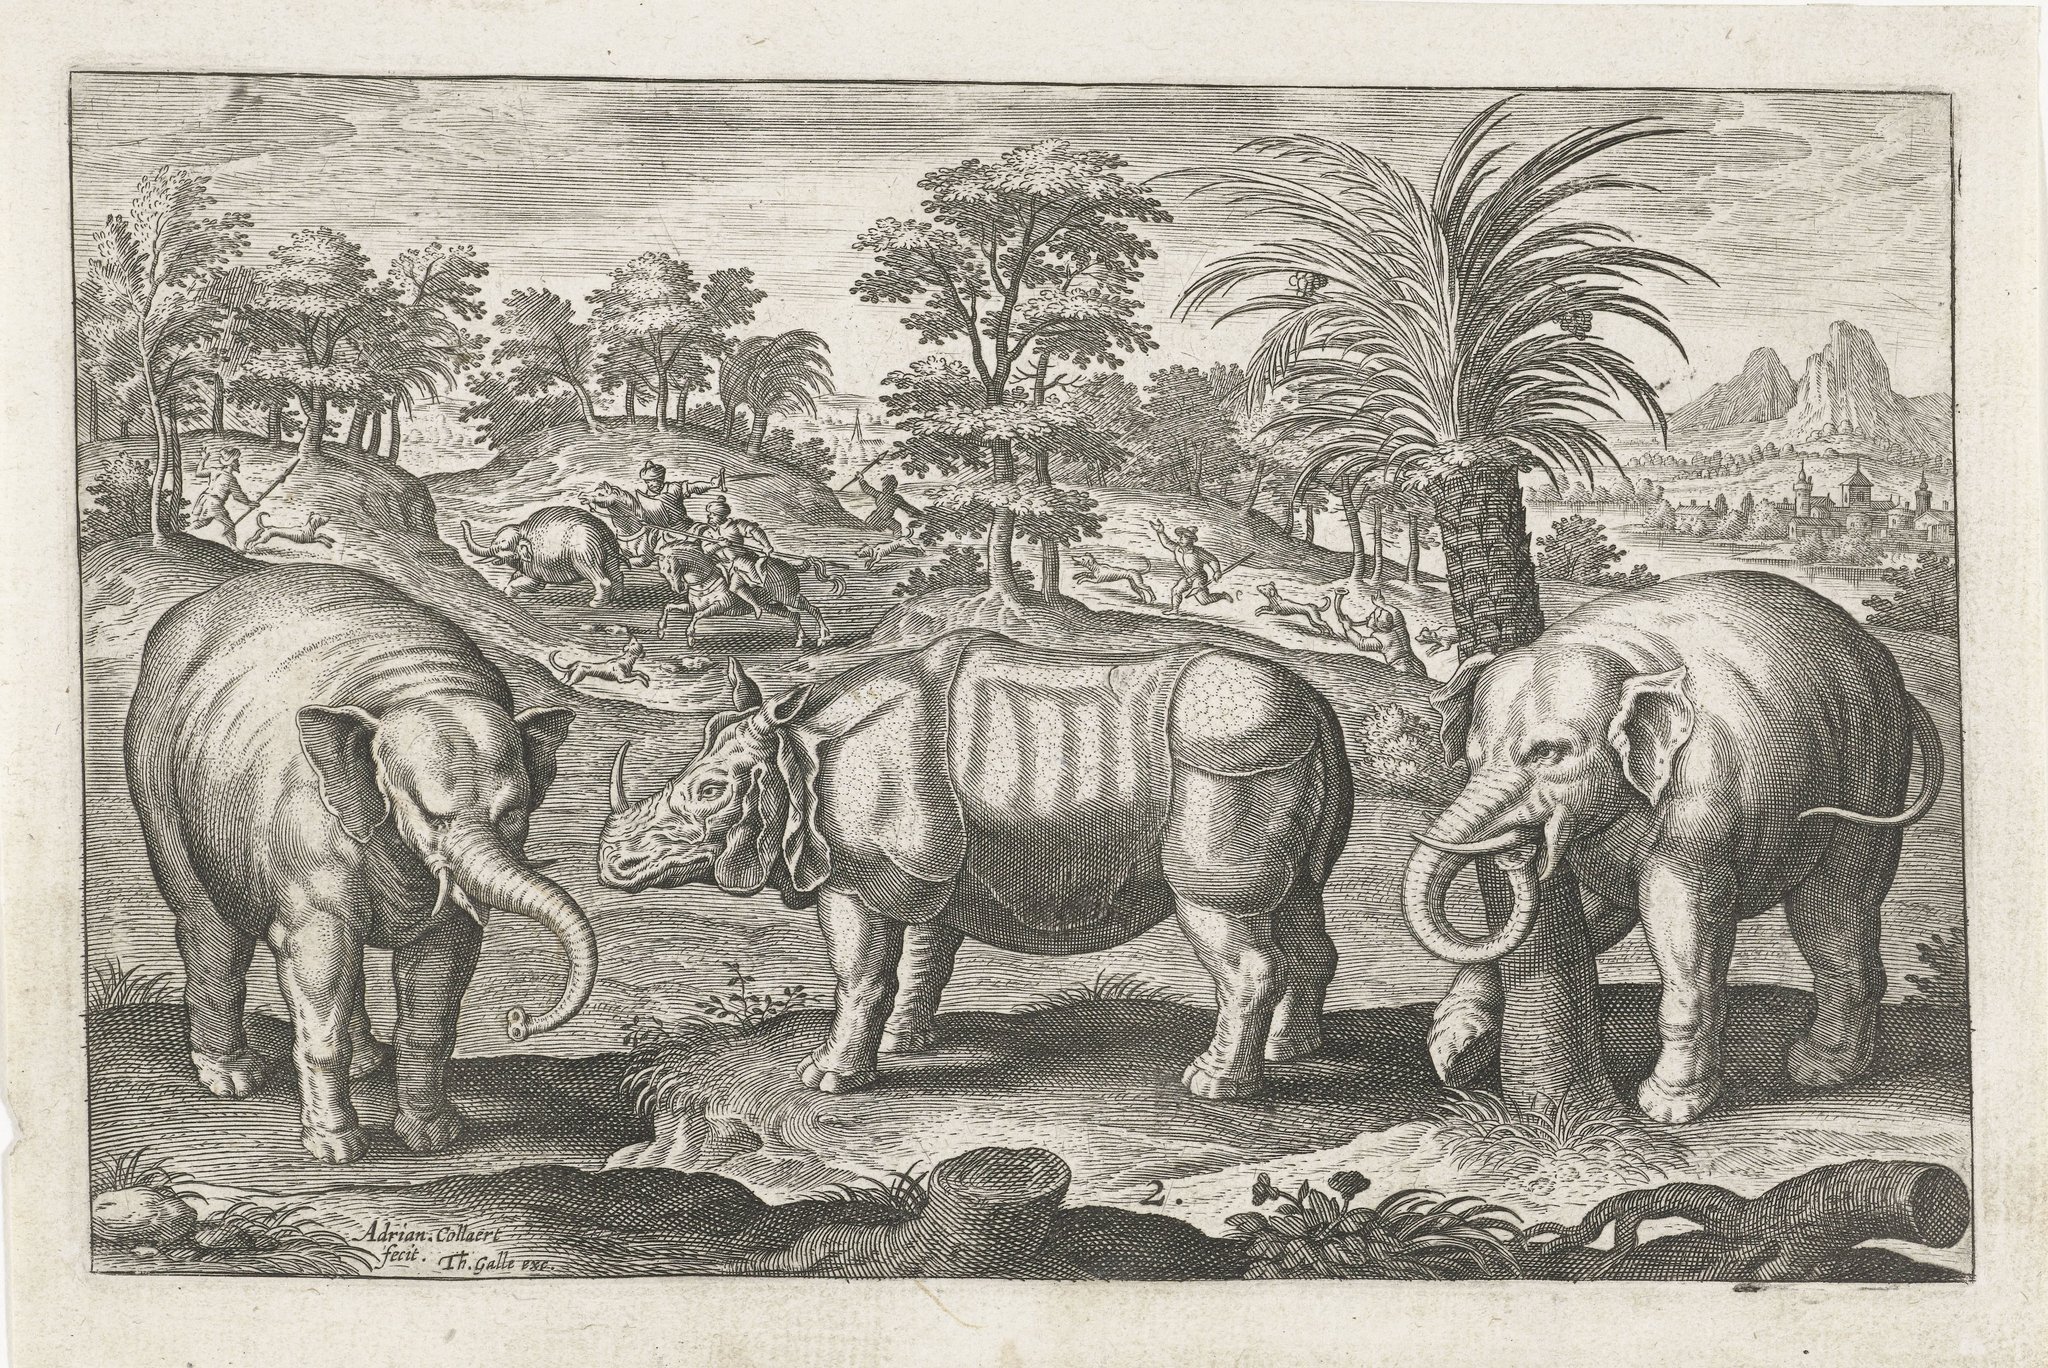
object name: print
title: Olifanten en neushoorn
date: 1595-1599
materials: paper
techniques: engraving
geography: antwerp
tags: hoofed animals: rhinoceros, trunked animals: elephant (+ animal killed by man), trunked animals: elephant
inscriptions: collector's mark: Lugt 2228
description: Op de voorgrond een neushoorn en twee olifanten. Op de achtergrond wordt er jacht gemaakt op een olifant. De prent maakt deel uit van een serie met dieren als onderwerp.